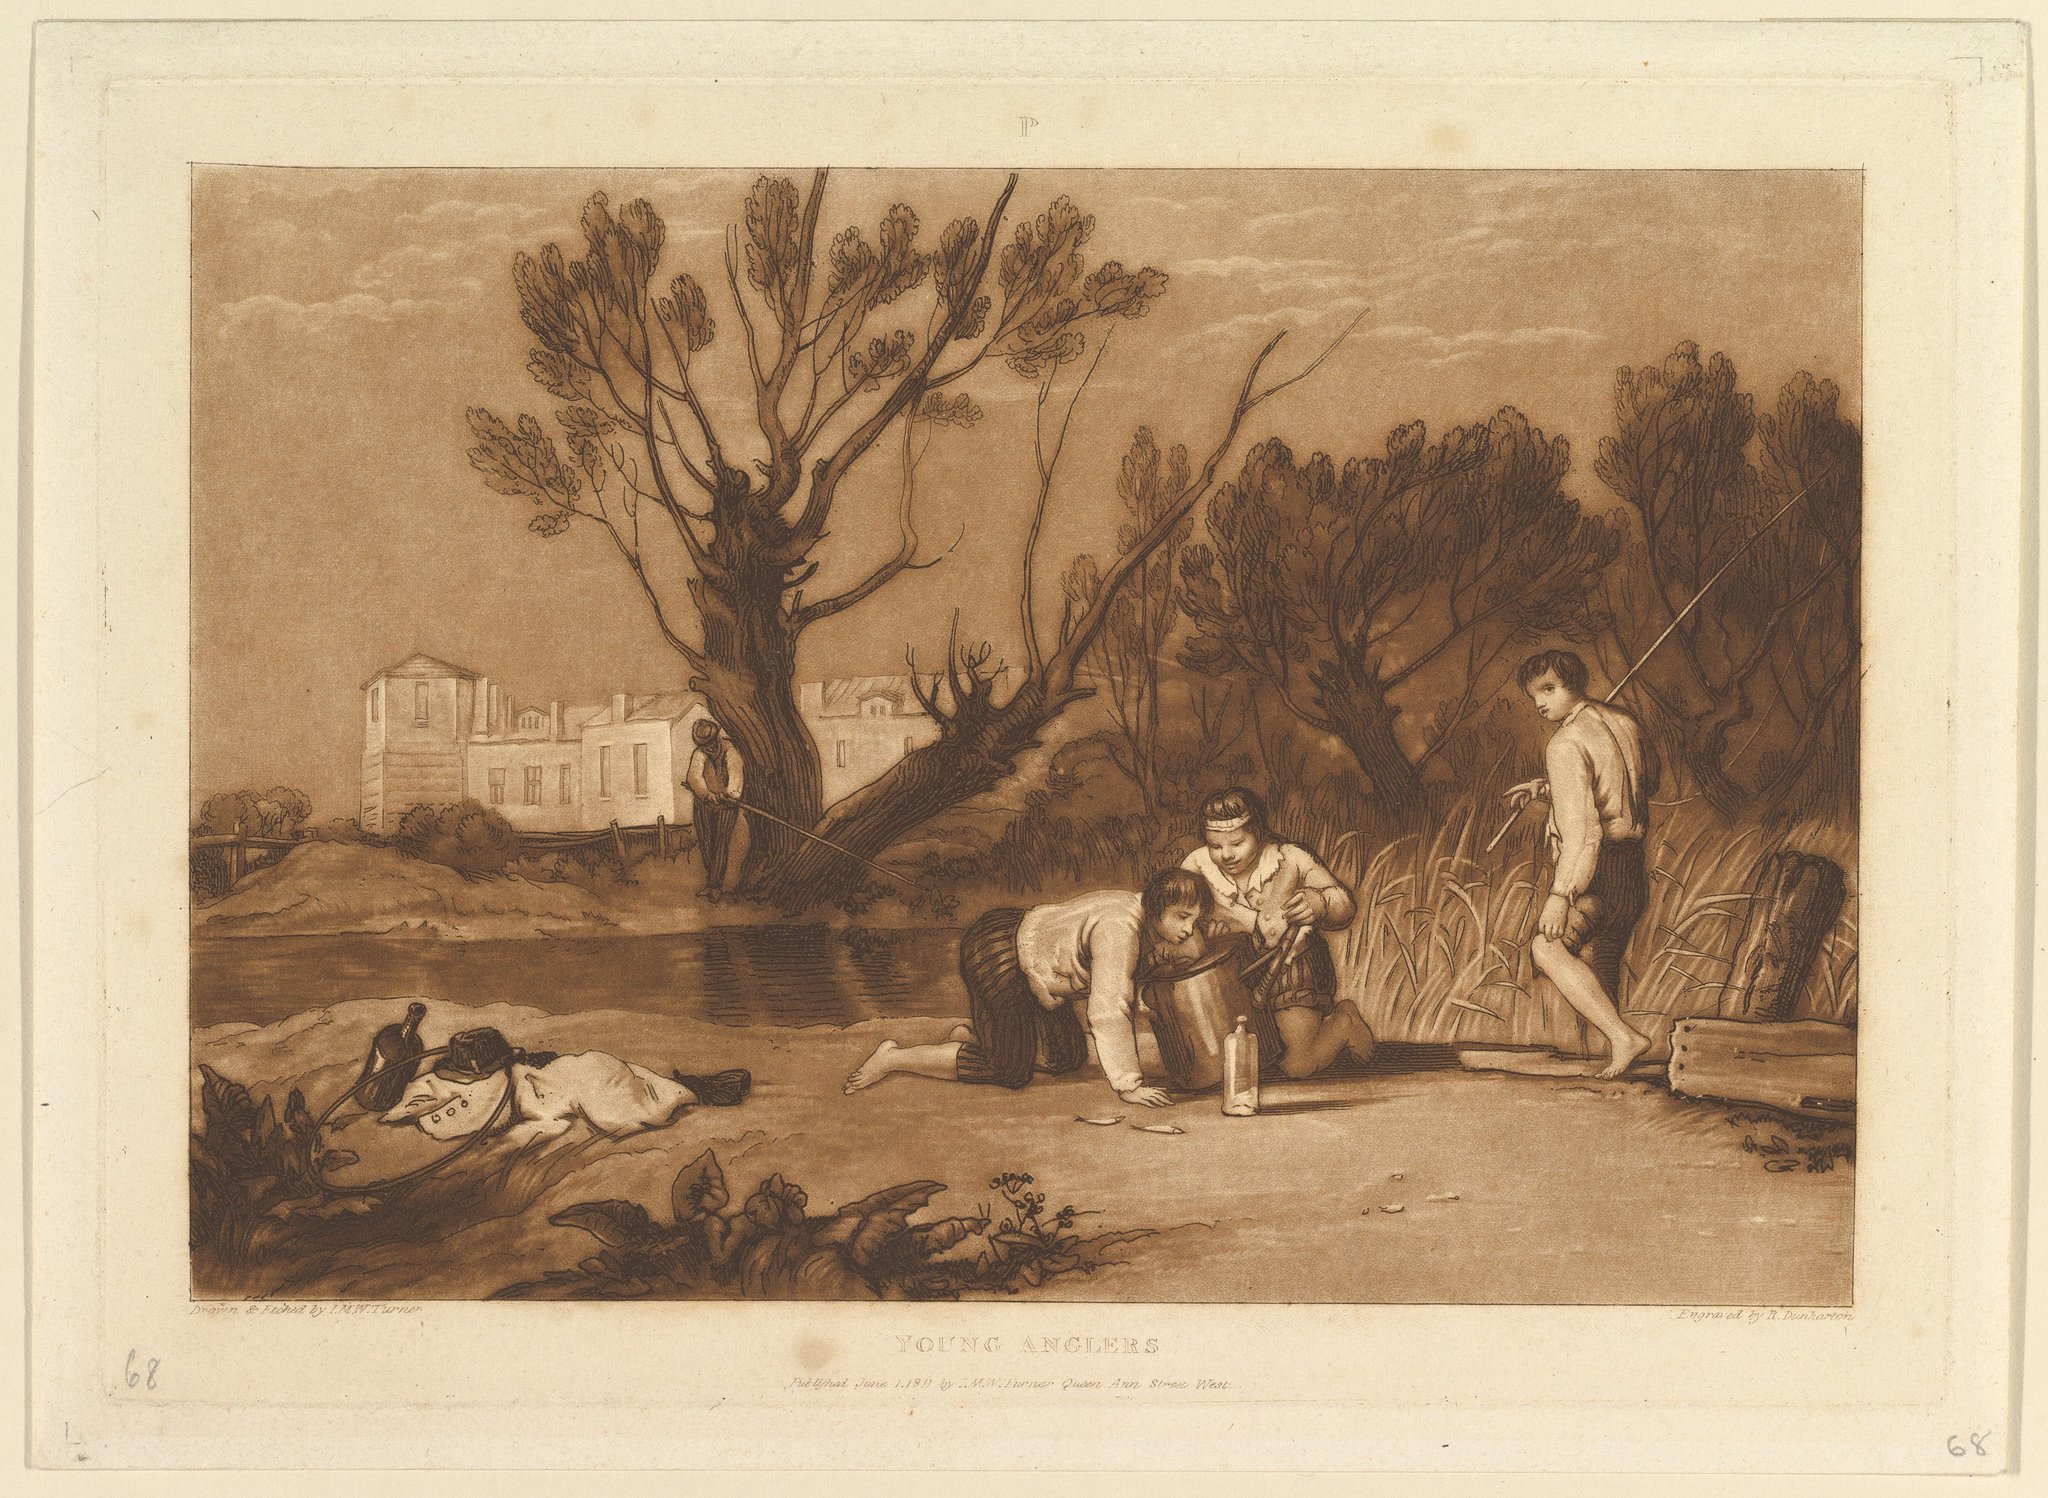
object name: print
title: Young Anglers (Liber Studiorum, part VII, plate 32)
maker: joseph mallord william turner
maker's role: artist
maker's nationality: british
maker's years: 1775-1851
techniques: etching, mezzotint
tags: boys,fishing,ponds